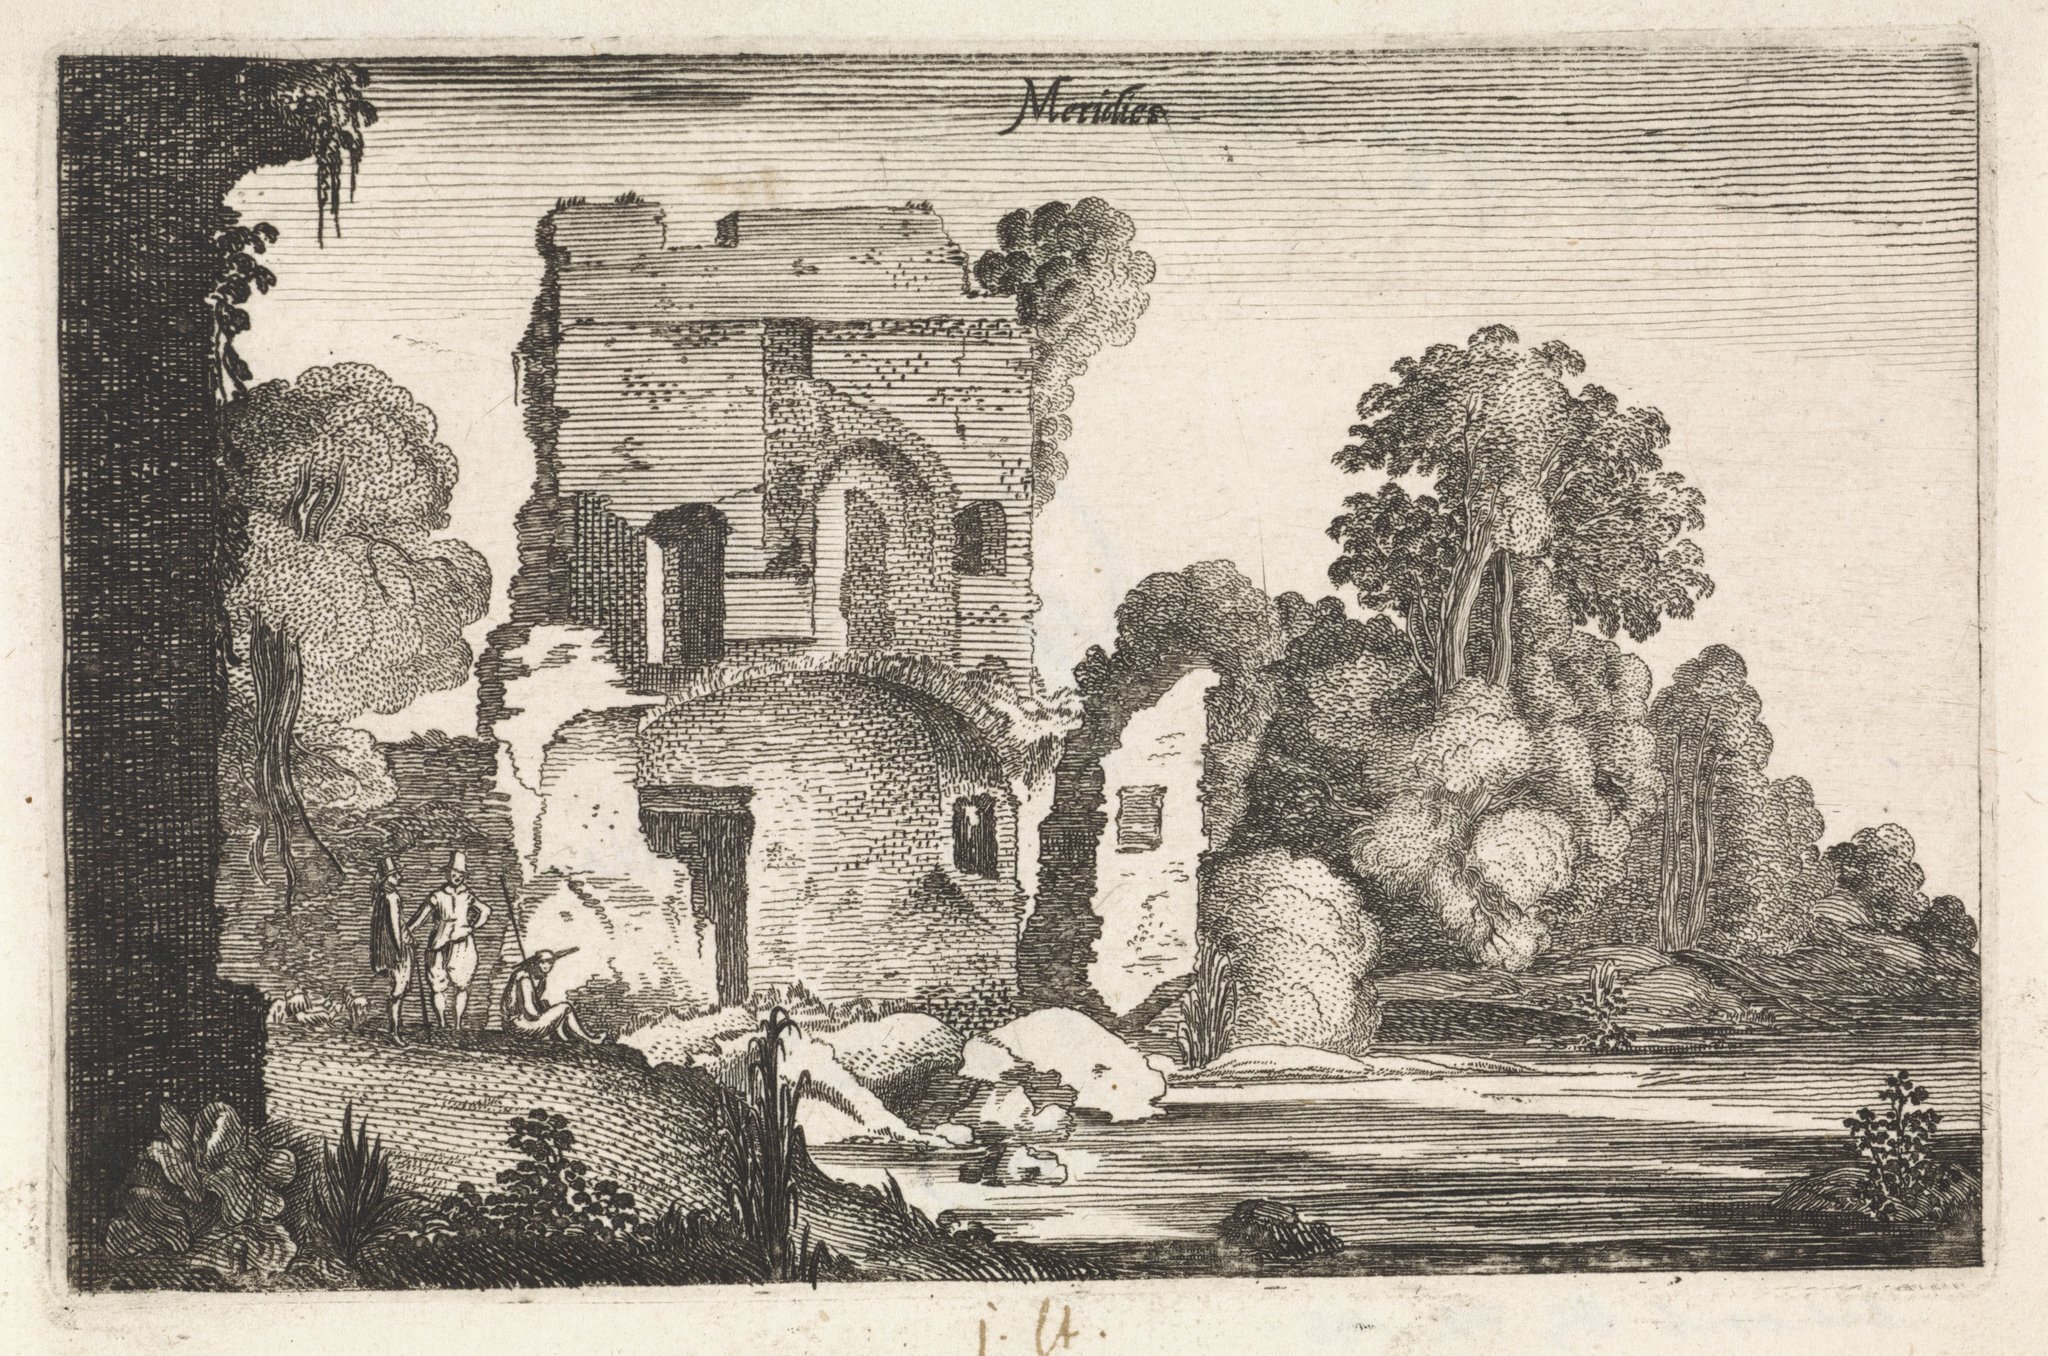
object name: print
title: Meridies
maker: jan van de velde (ii)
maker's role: draughtsman, painter, print maker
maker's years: 1593-1641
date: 1603-1641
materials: paper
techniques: engraving, etching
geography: northern netherlands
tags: landscape with ruins, afternoon ~ landscape (sometimes titled 'meridies')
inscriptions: title: ‘MERIDIES’, caption: ‘i.lt.’, collector's mark: Lugt 2228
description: Landschap met een ruïne van toren, bomen en een rivier. Links twee staande mannenfiguren, een derde zit op de grond.